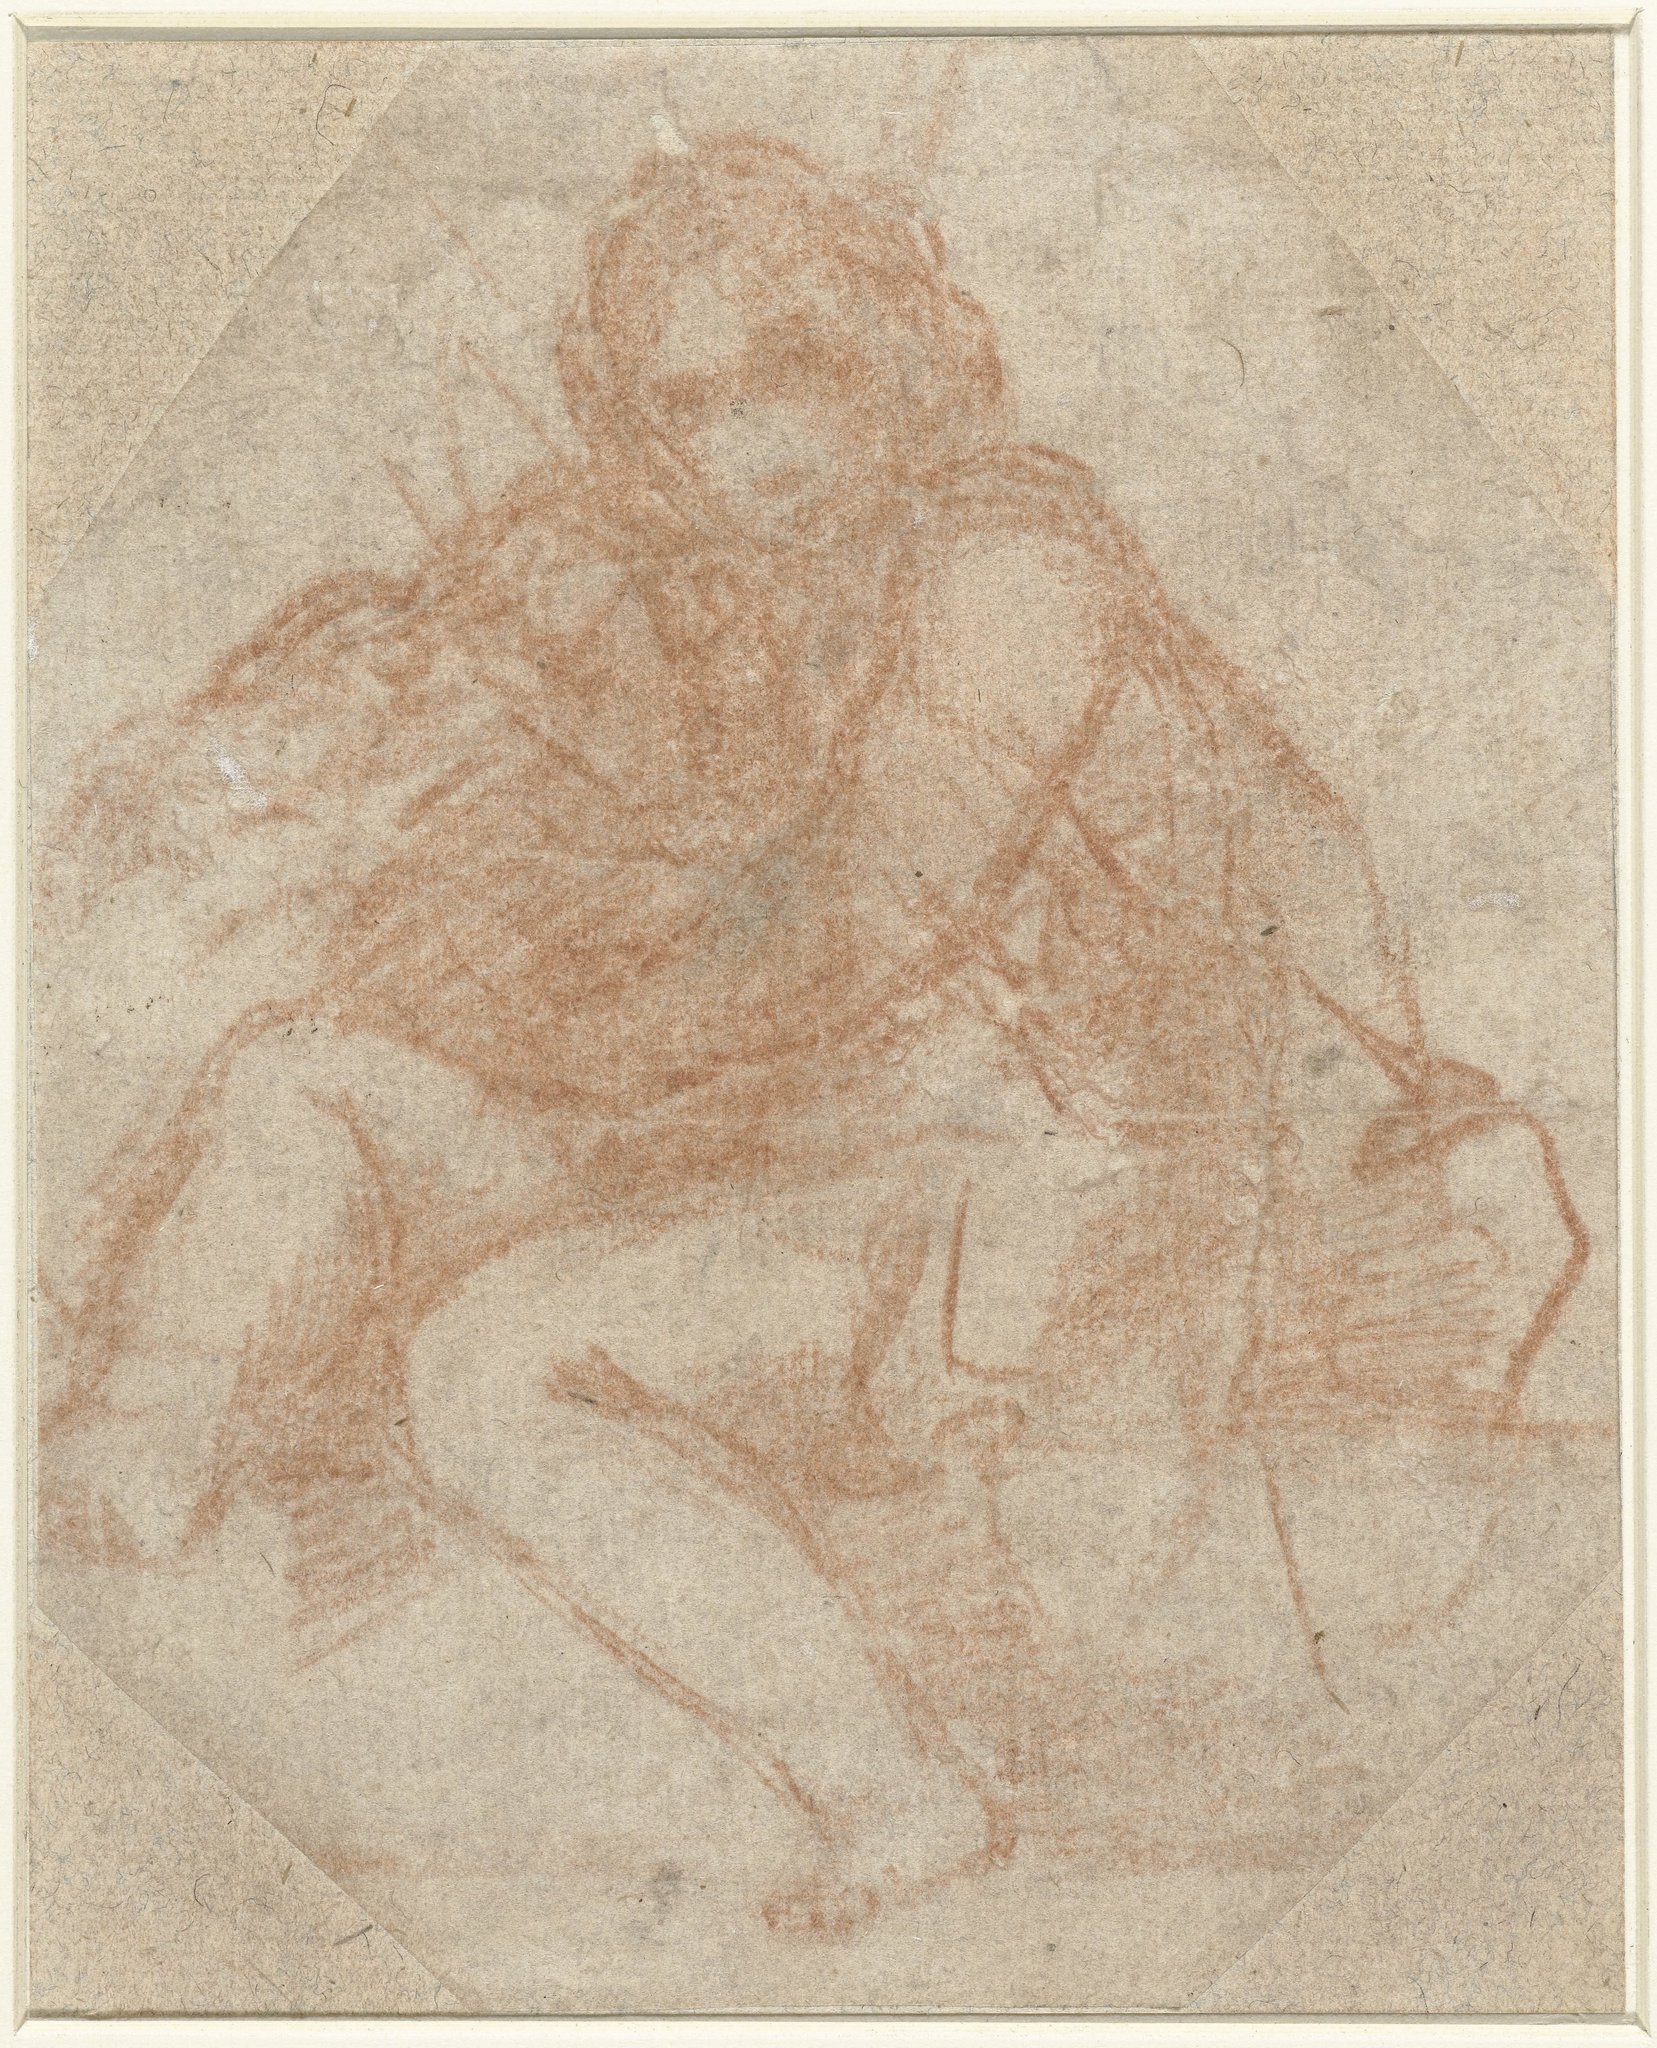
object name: drawing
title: Johannes de Doper met het lam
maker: Anonymous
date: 1500-1549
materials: chalk, paper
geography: emilia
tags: john the baptist; possible attributes: book, reed cross, baptismal cup, honeycomb, lamb, staff